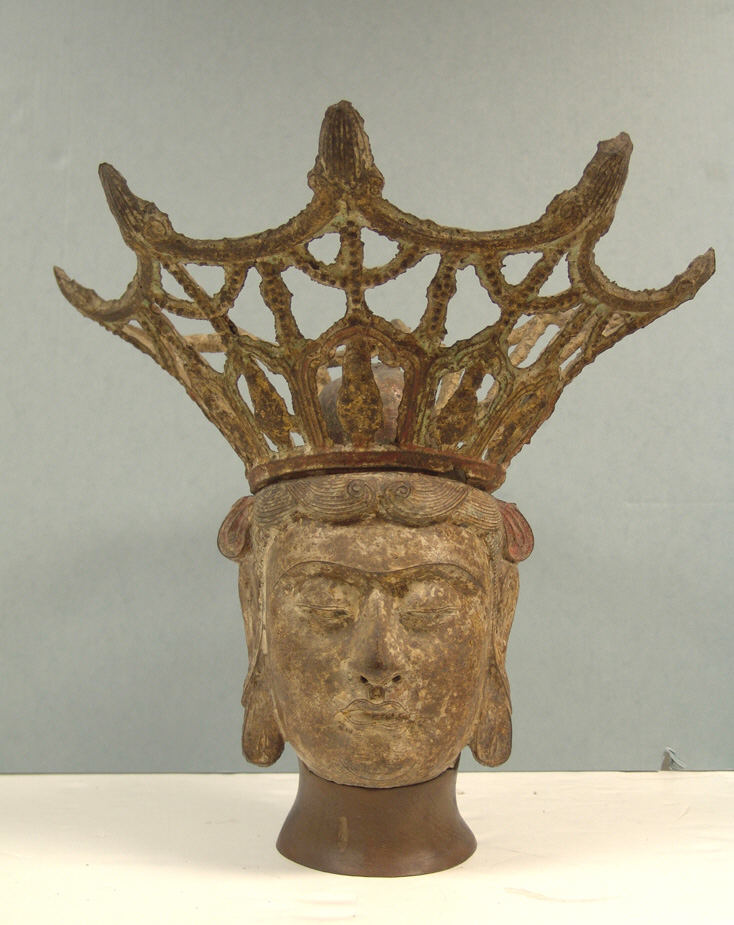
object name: head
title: Head of a Bodhisattva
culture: chinese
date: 1368-1644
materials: iron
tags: heads,buddhism,bodhisattvas